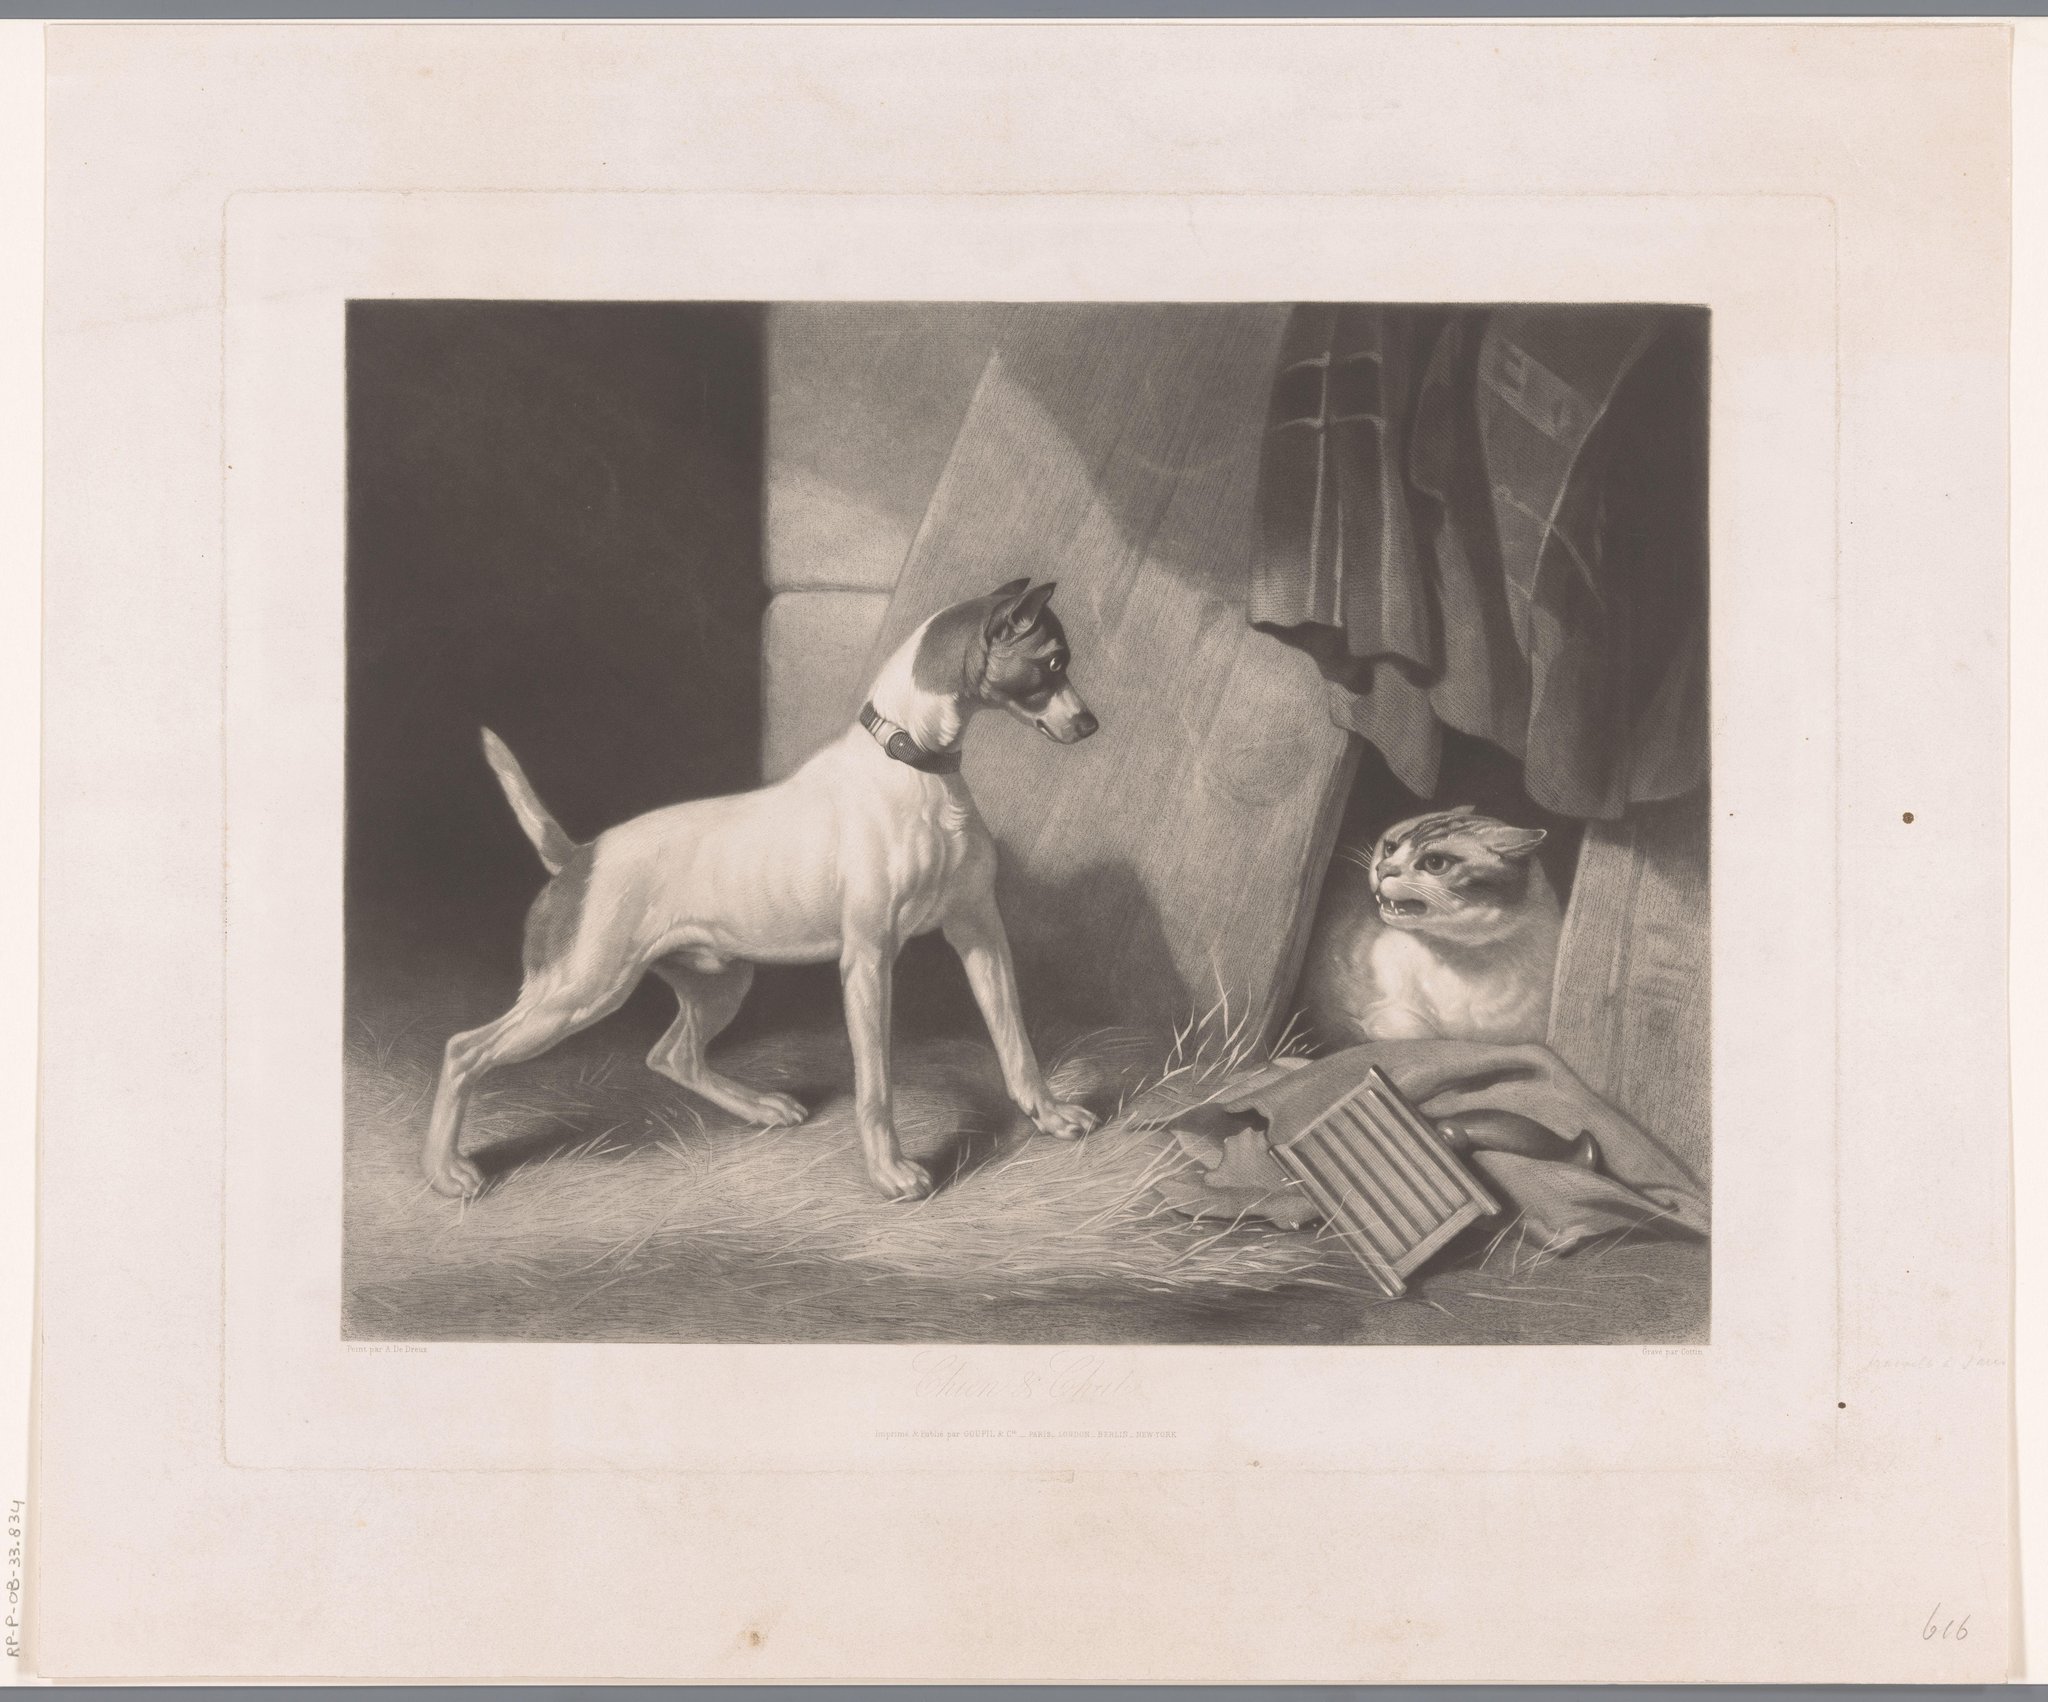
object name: print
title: Chien & Chat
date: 1866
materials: paper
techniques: etching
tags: cat, dog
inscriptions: collector's mark: Lugt 2228